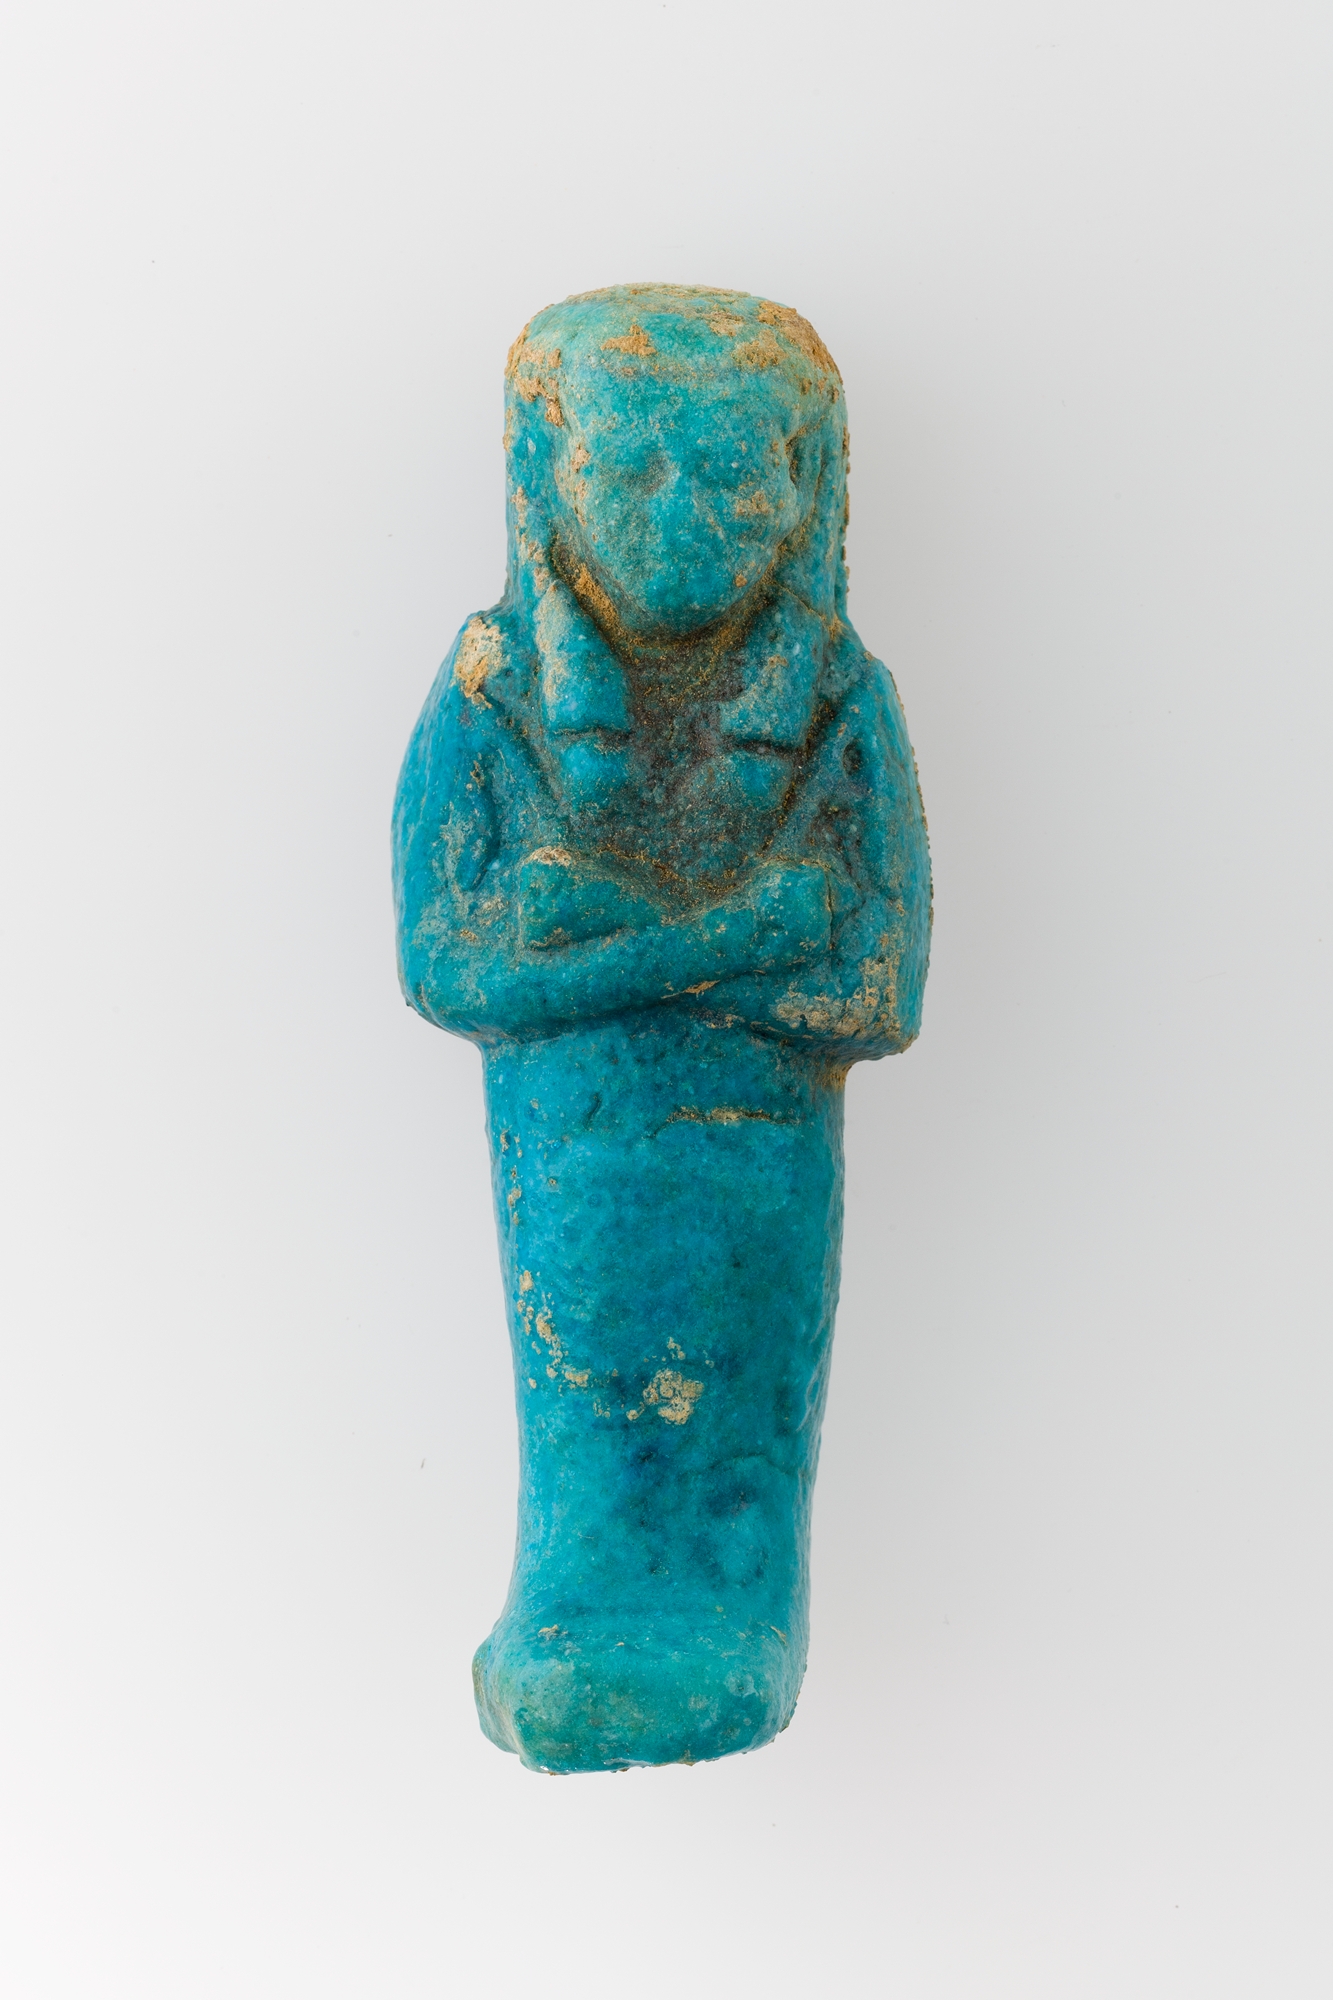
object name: shabti, henettawy c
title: Worker Shabti of Henettawy (C), Daughter of Isetemkheb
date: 990-970 BCE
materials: faience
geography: egypt